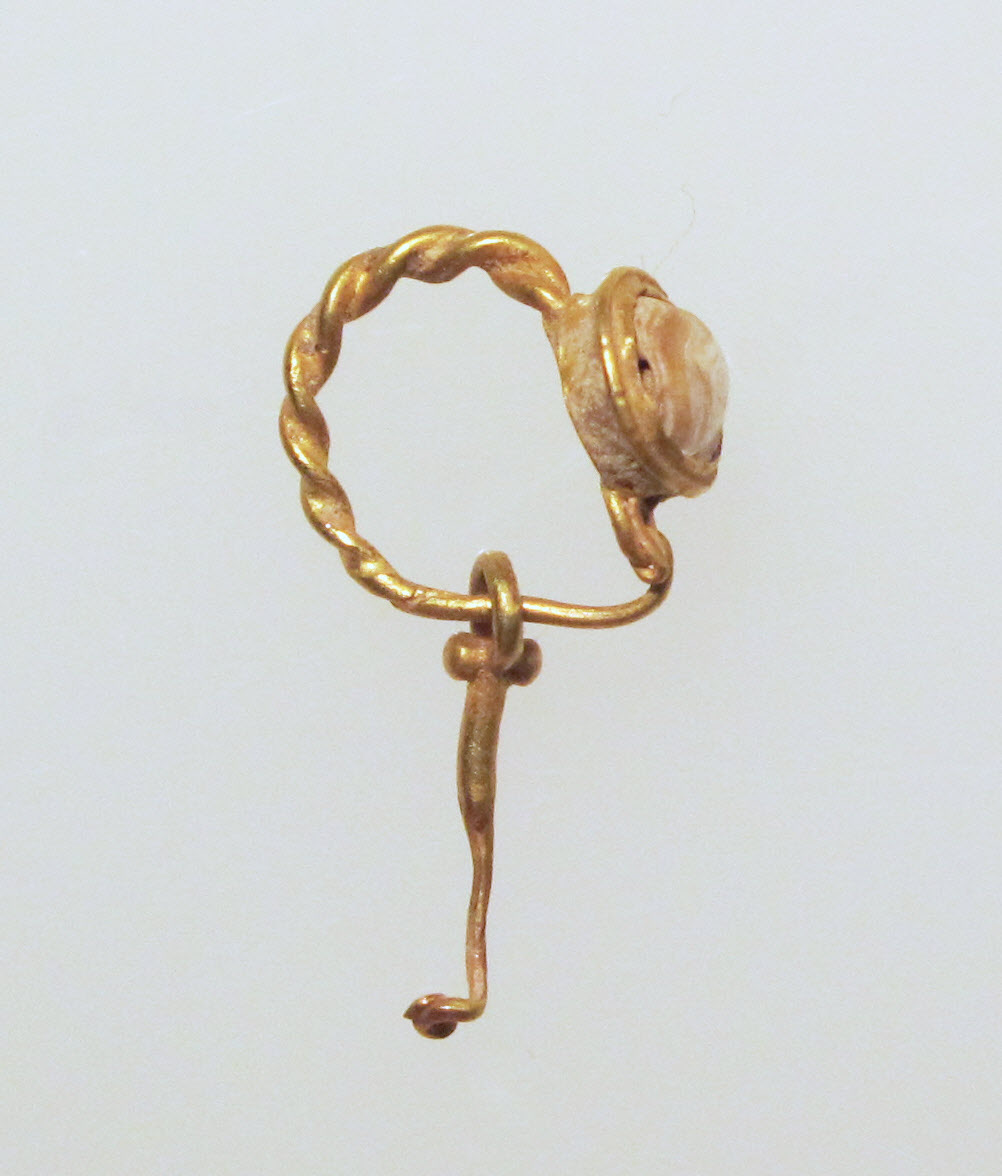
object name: earring with pendant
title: Gold earring with pearl setting and pendant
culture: roman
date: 670 BCE-330 CE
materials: gold